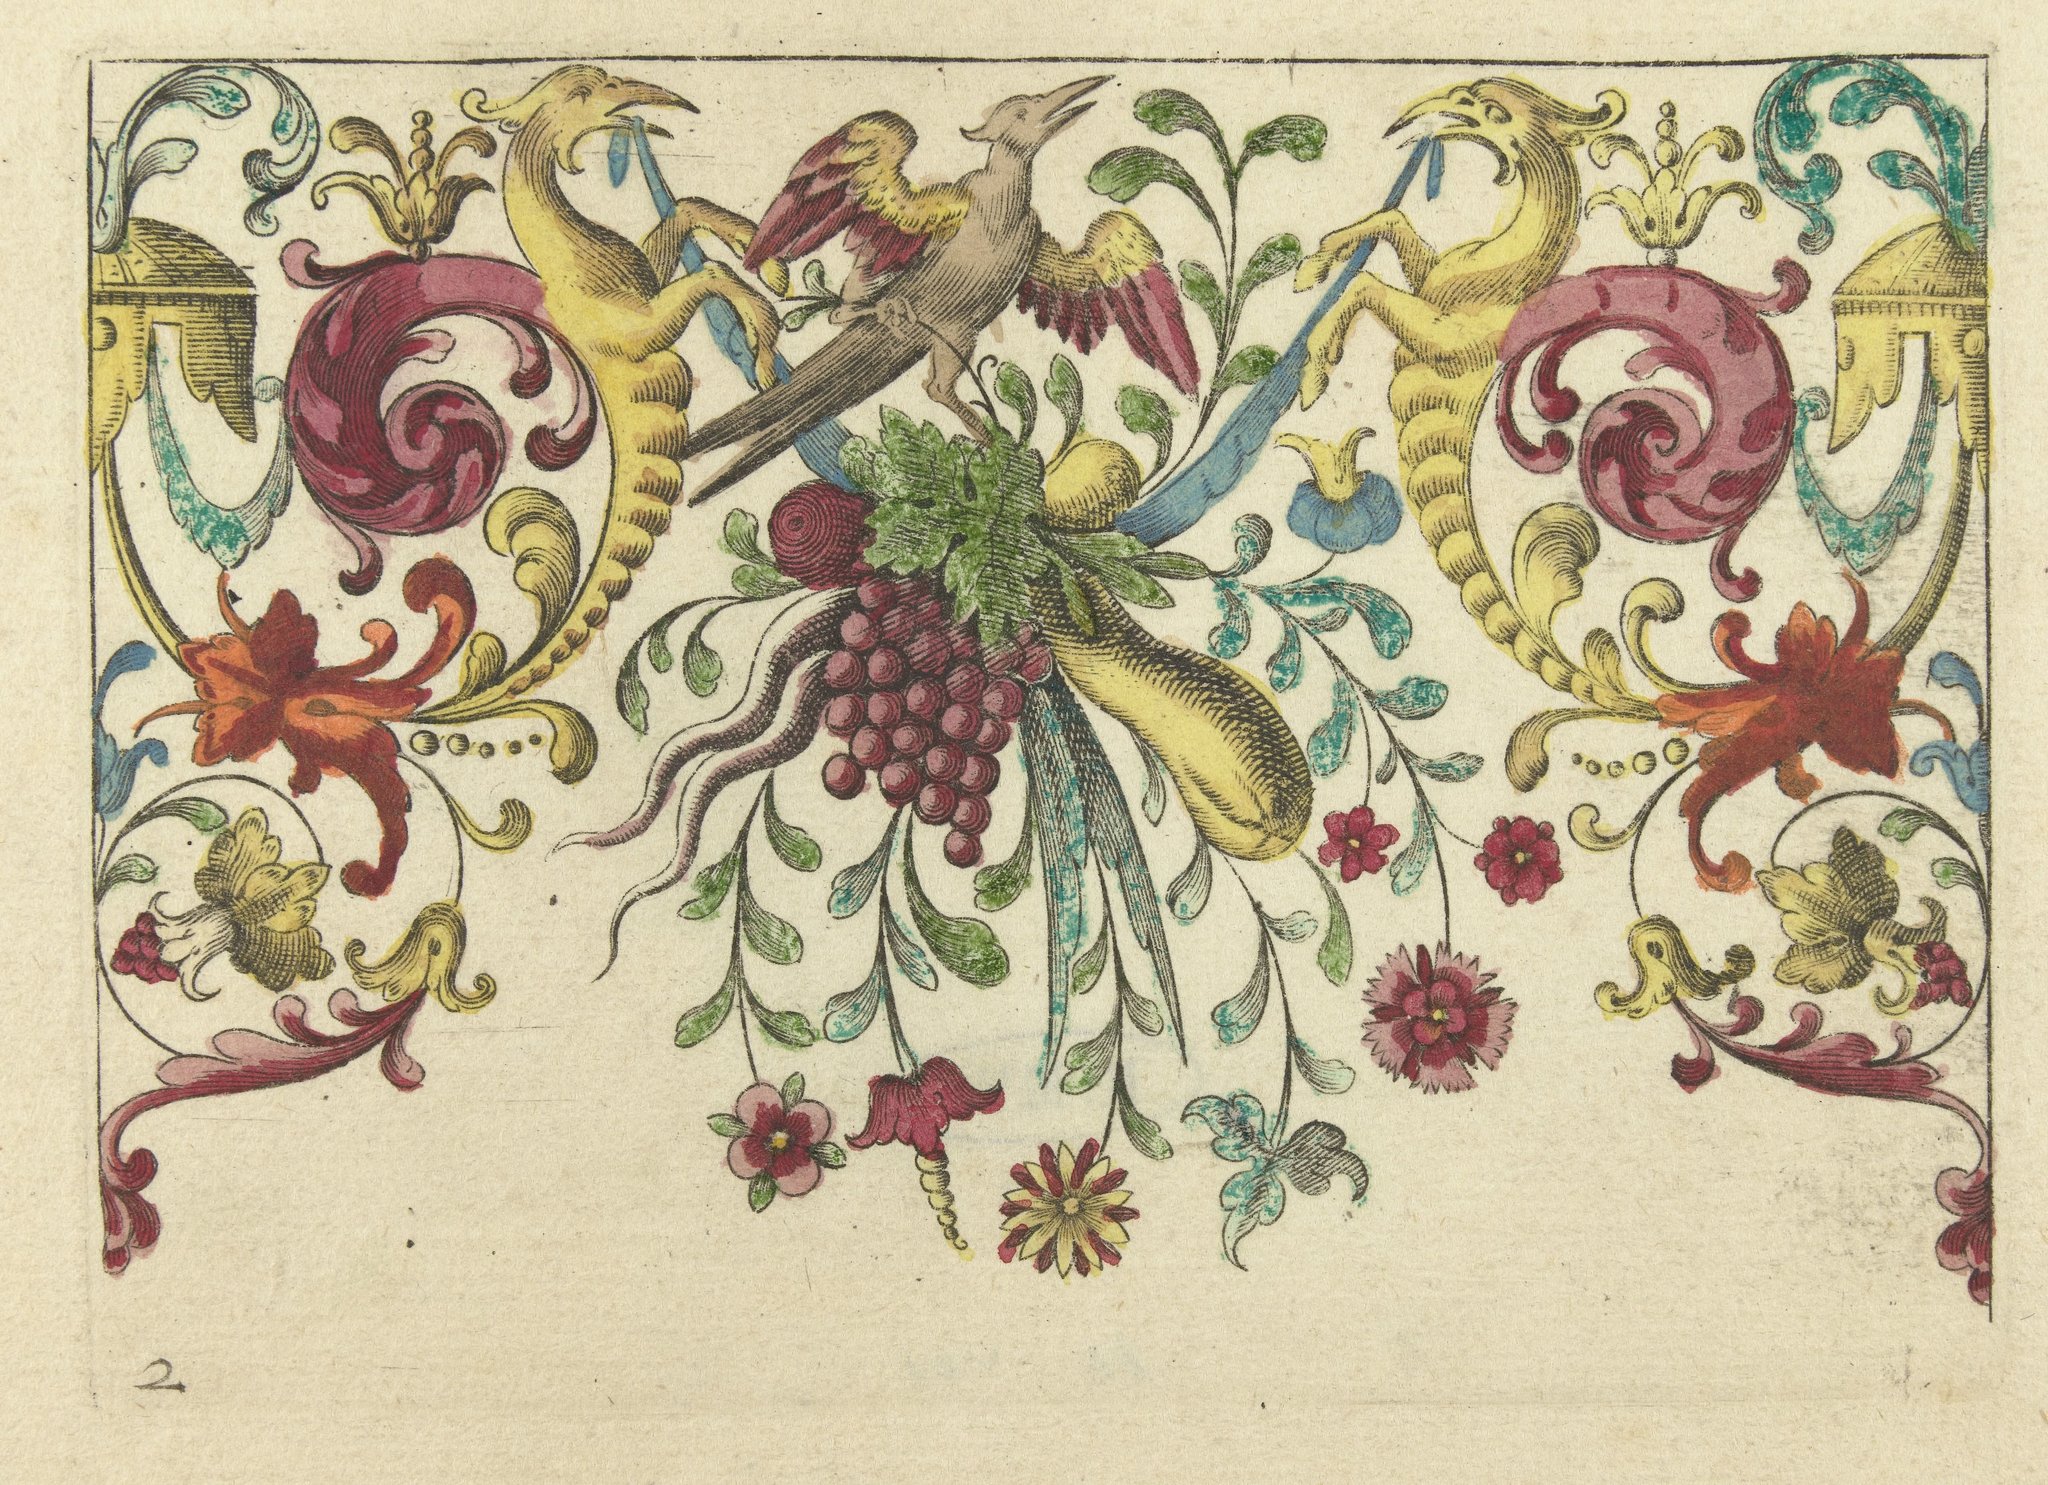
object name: print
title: Vruchtenguirlandes / Früchtenbüchlein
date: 1596-1633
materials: paper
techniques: engraving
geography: germany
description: In het midden hangt een druiventros tussen twee fantasiewezens met vogelkoppen. Blad uit een serie van 12 bladen, genummerd 1-8.